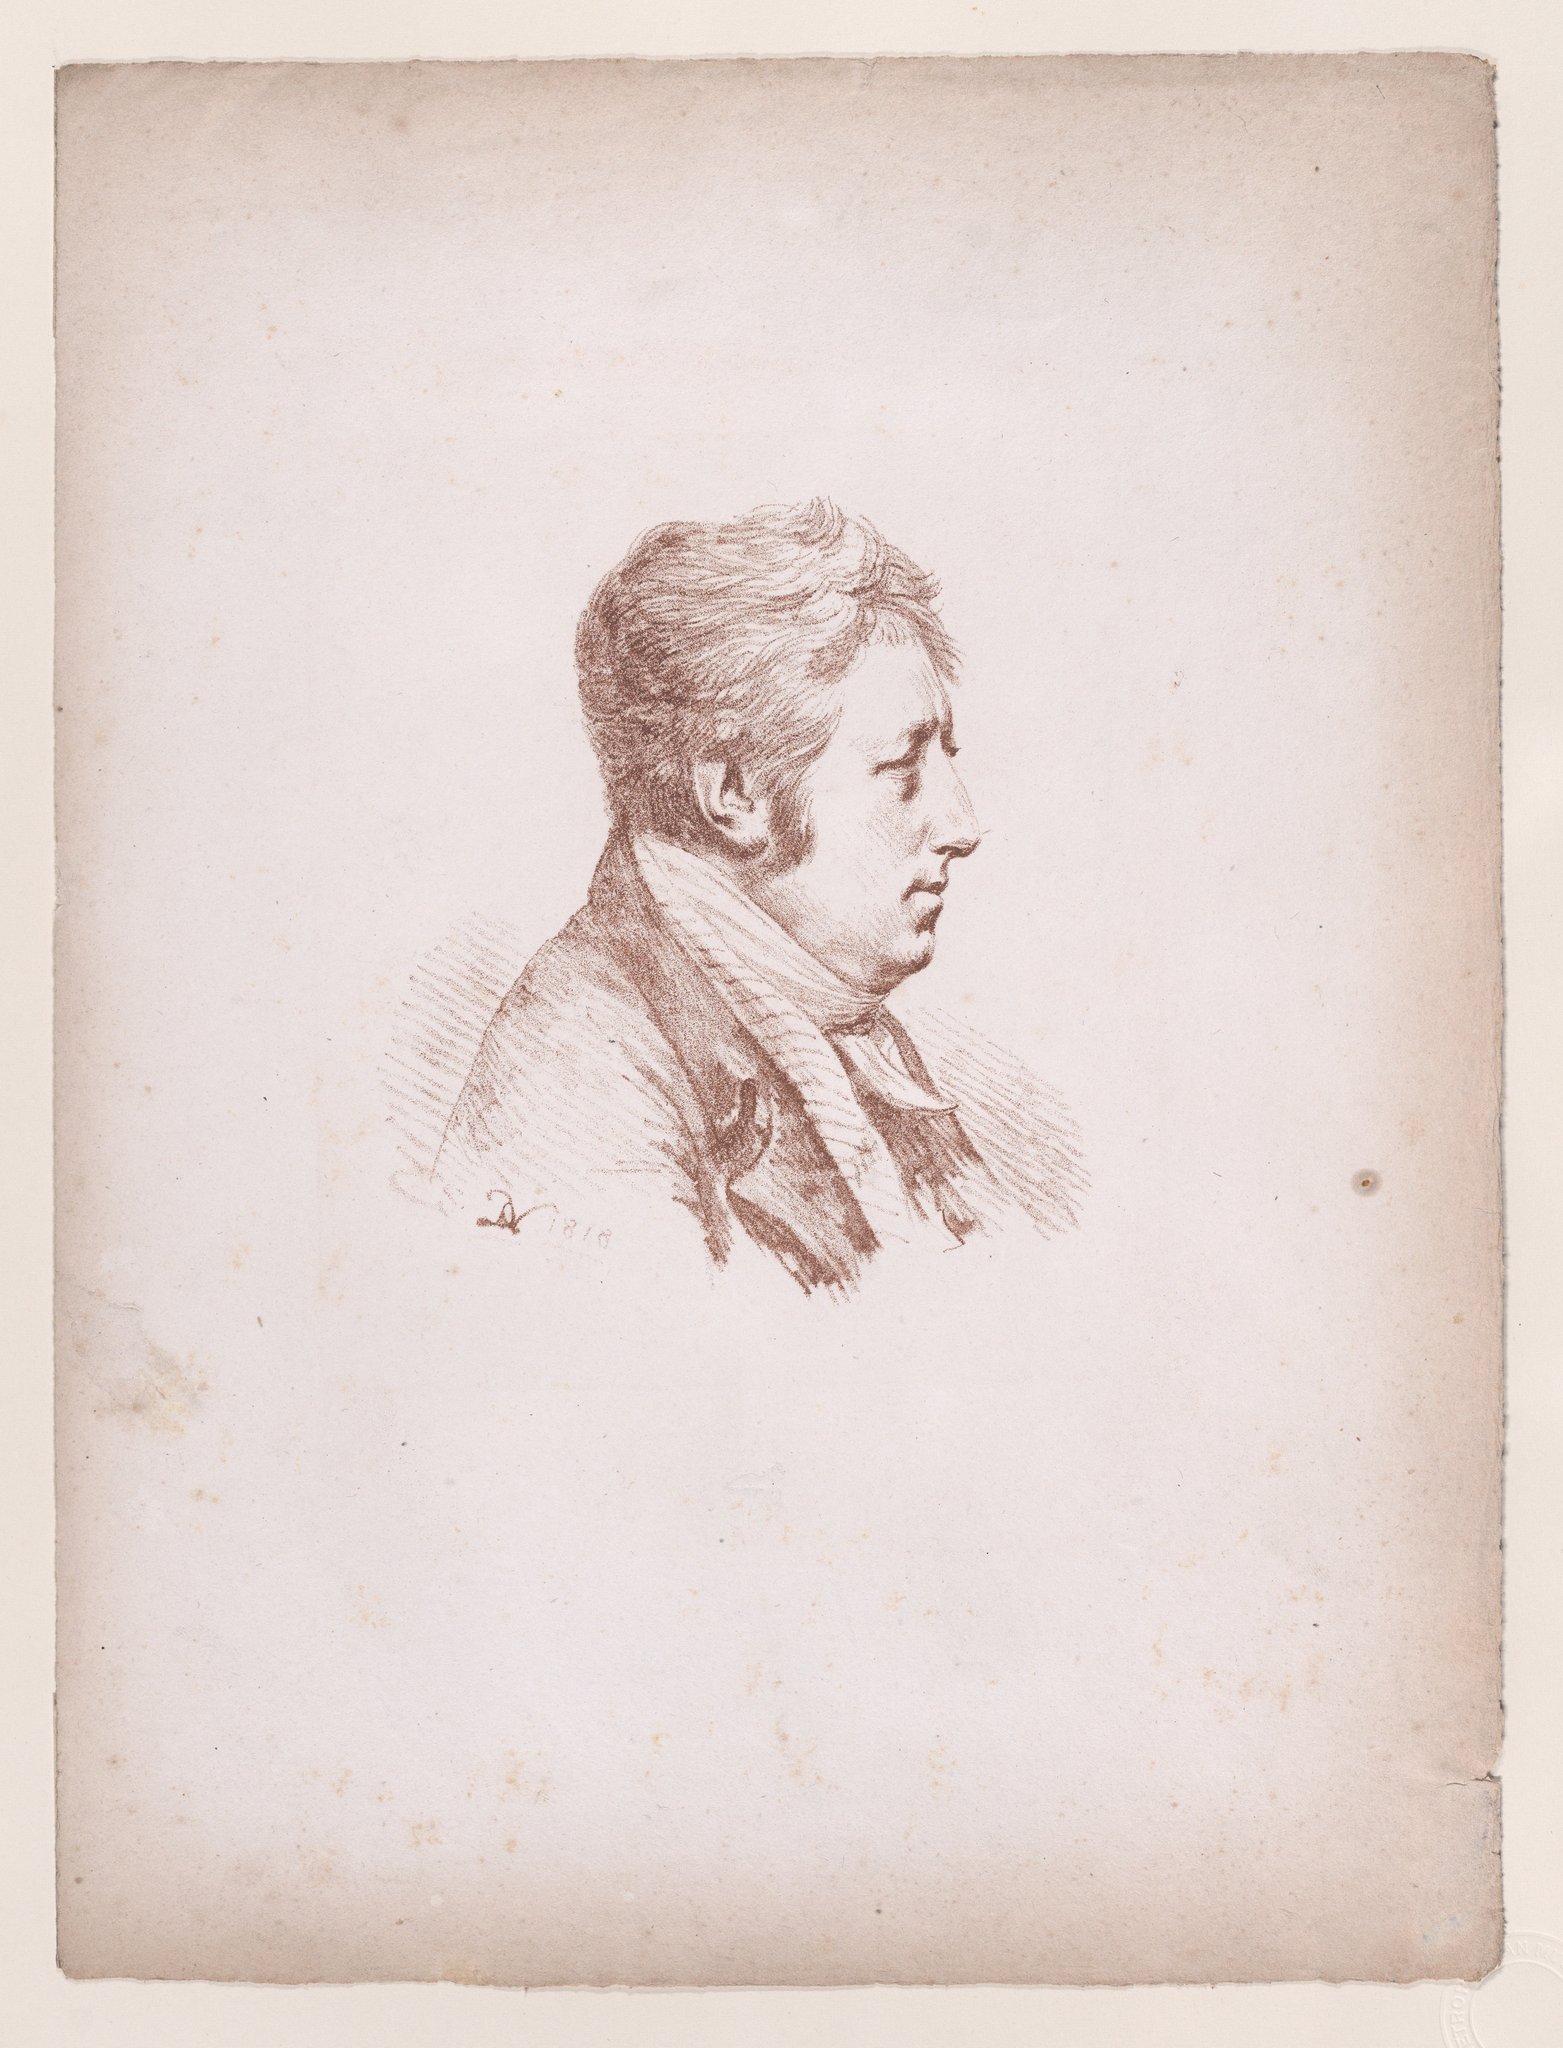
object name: print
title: Bust of a man in profile, facing right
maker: baron dominique vivant denon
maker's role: artist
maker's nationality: french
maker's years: 1747-1825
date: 1818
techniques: lithograph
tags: men,portraits,profiles